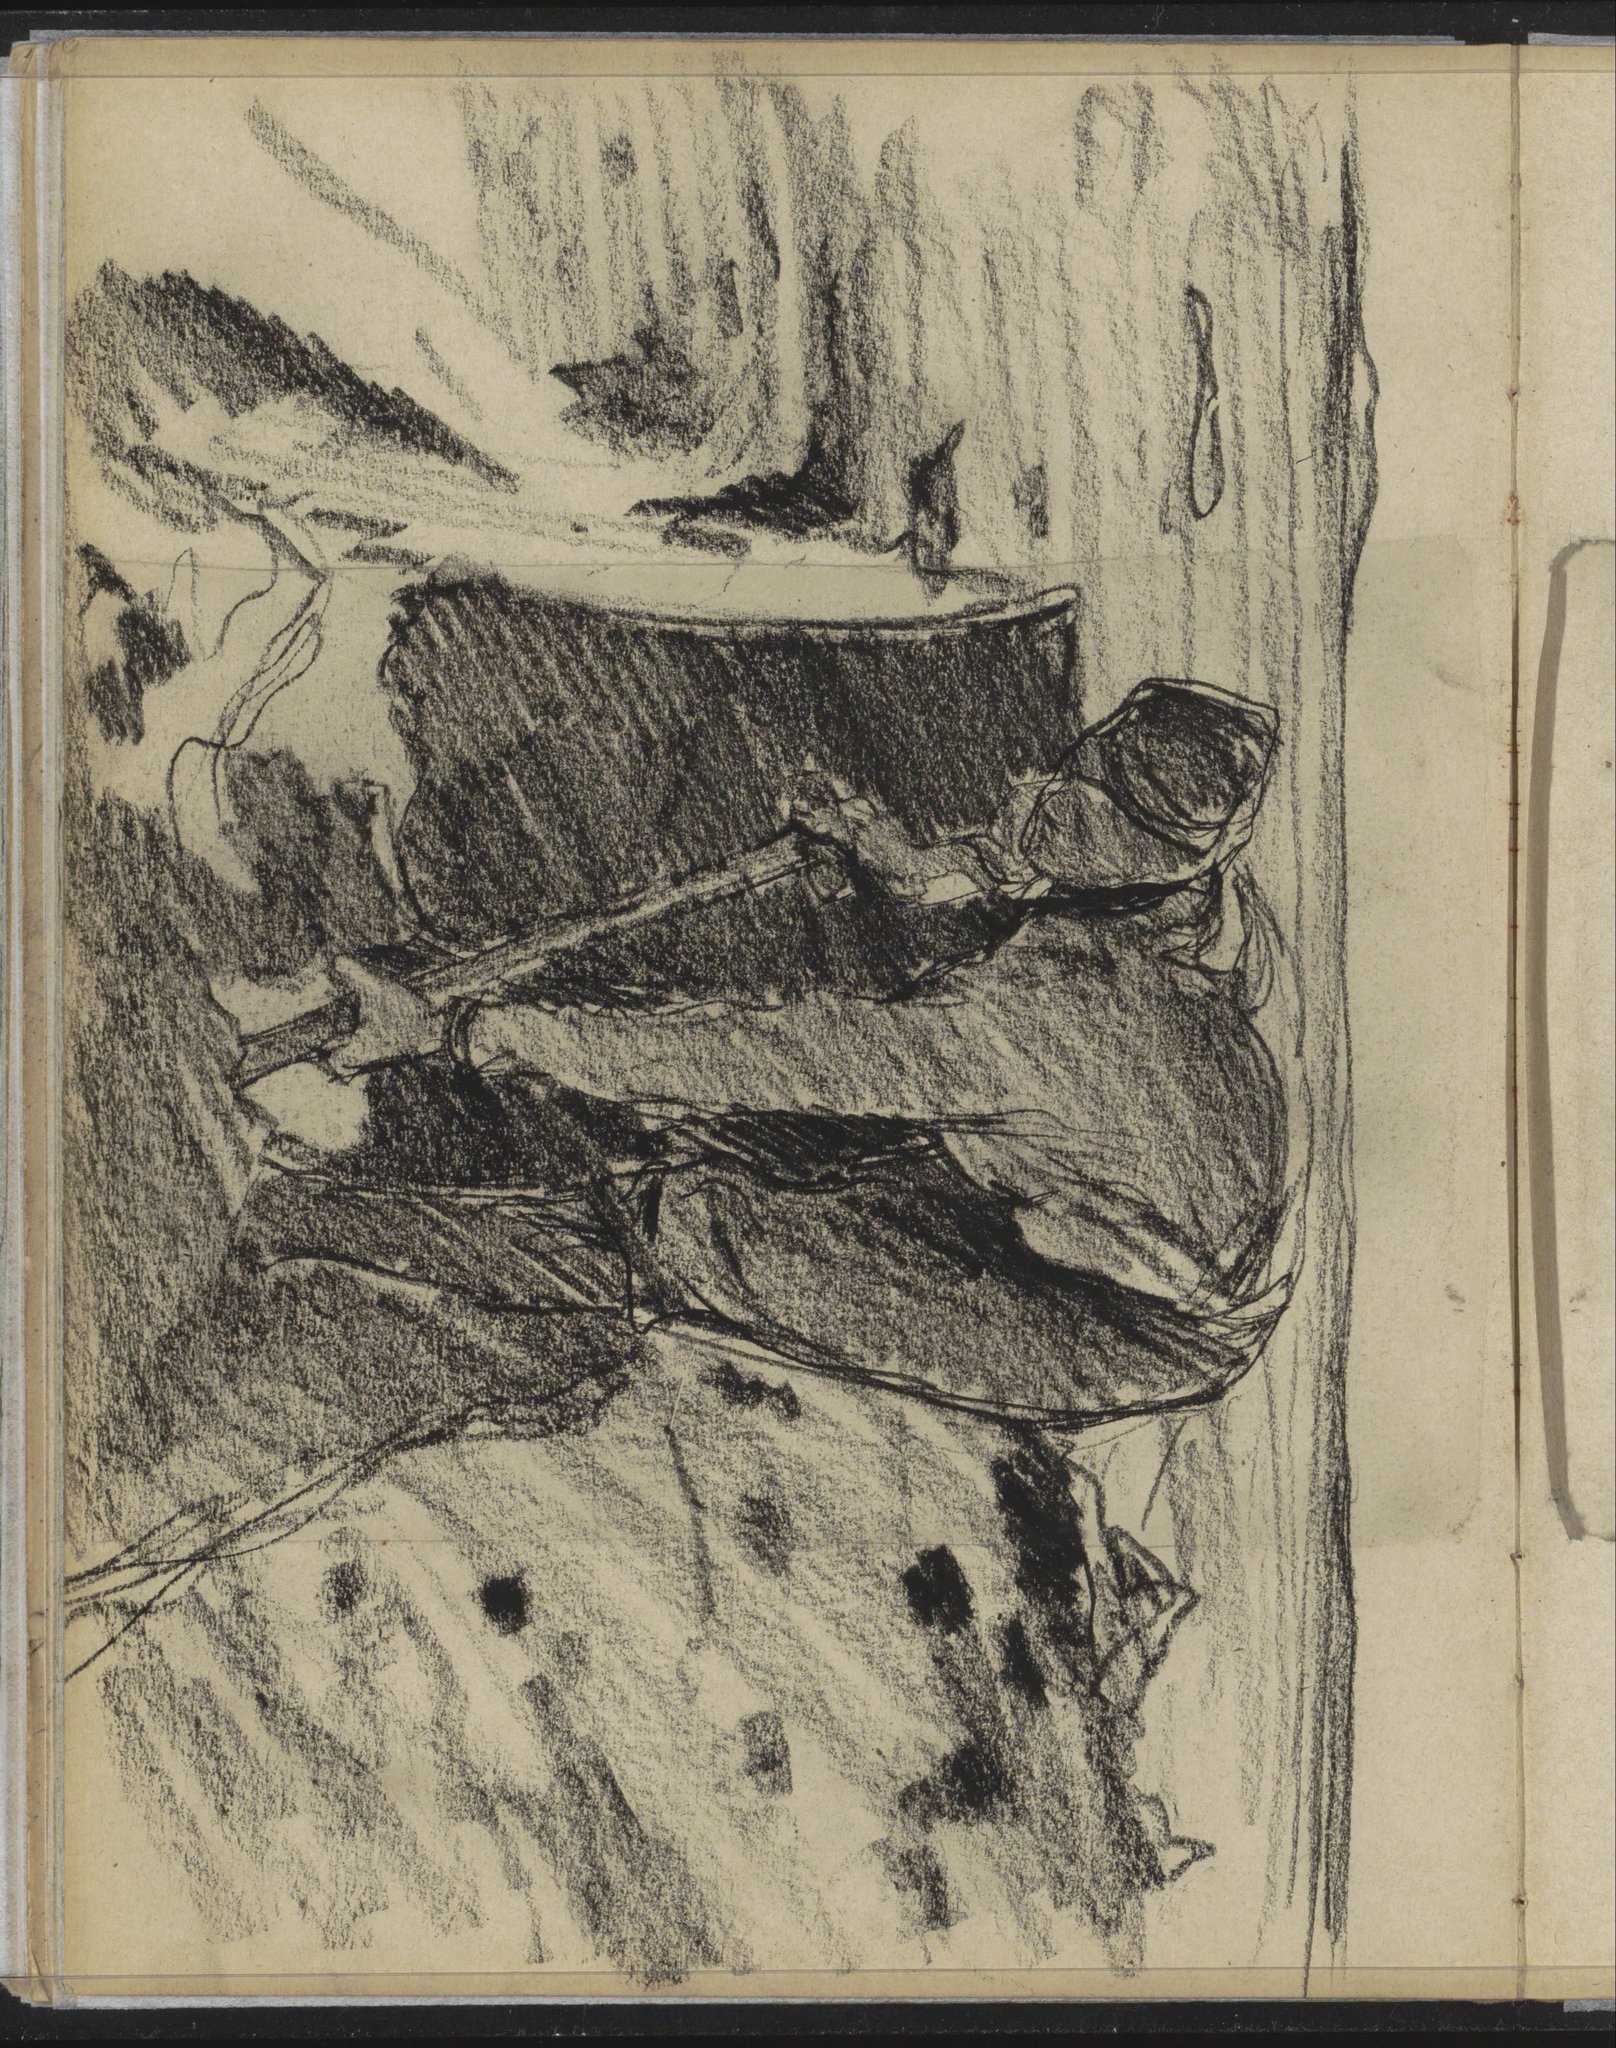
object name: sketchbook leaf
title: Gravende heiwerker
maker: willem witsen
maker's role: draughtsman, painter, print maker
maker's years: 1860-1923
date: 1884-1887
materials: chalk, paper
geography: ewijkshoeve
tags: building-site (+ men (labourers))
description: Pagina 88 uit een schetsboek met 49 bladen.